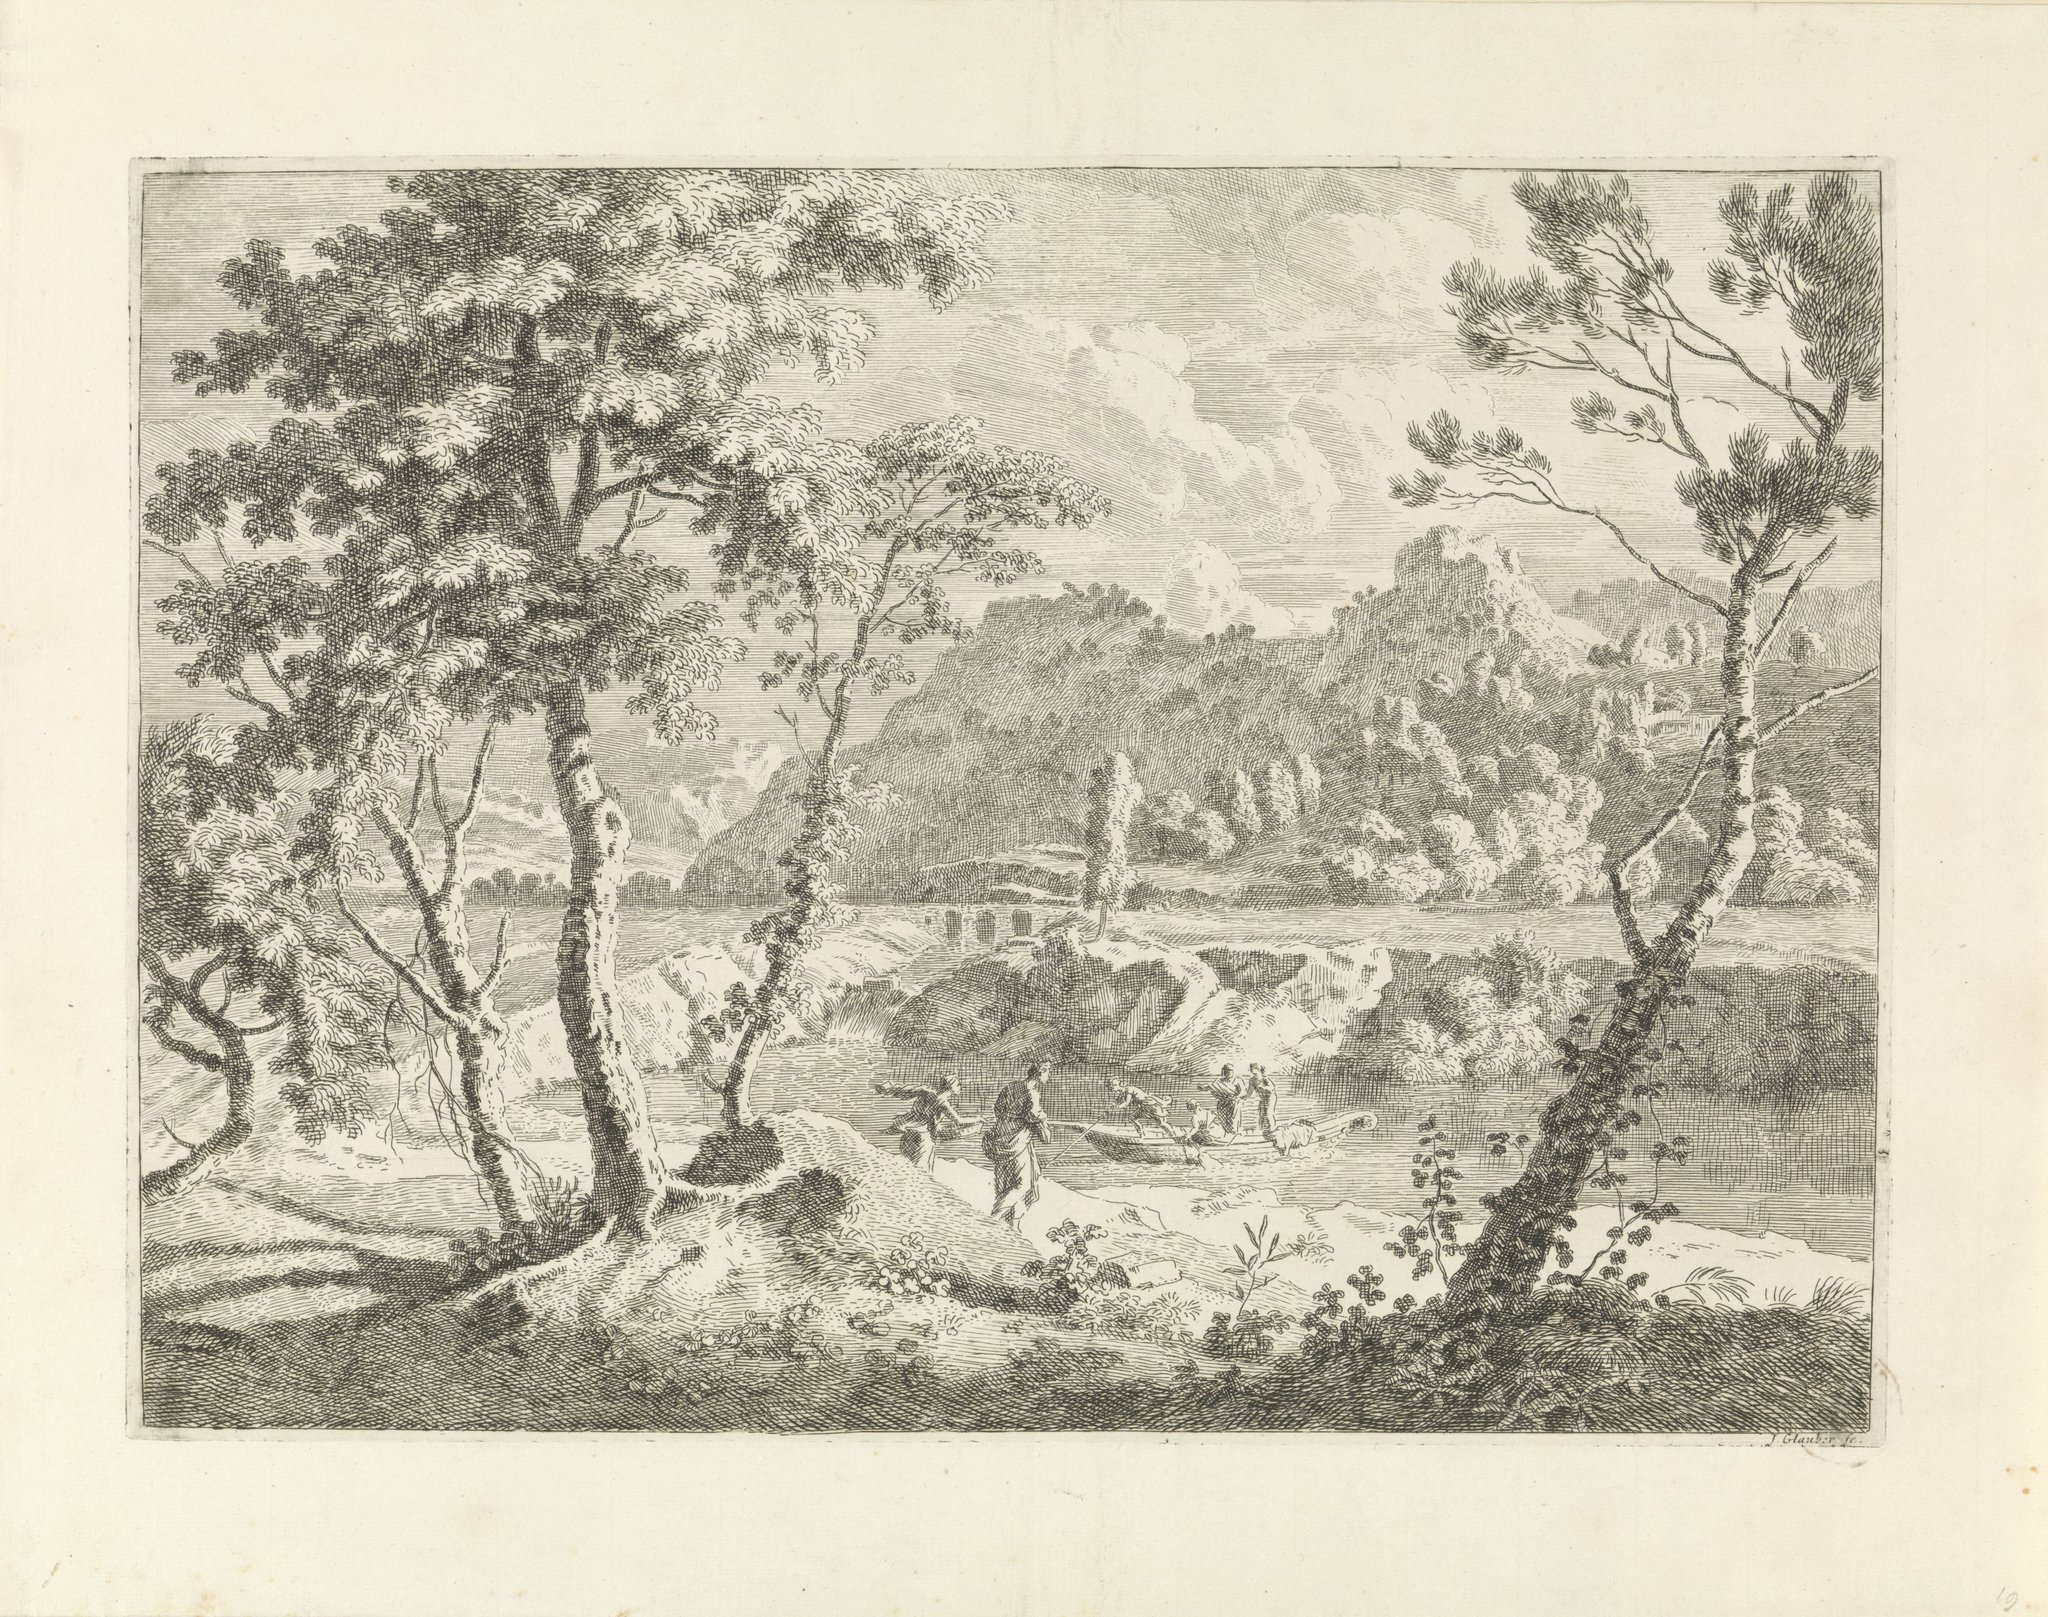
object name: print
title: Rivierlandschap met een boot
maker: johannes glauber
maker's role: draughtsman, painter, print maker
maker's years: 1646-1726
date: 1656-1726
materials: paper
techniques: etching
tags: (high) hill, rowing-boat, canoe, etc., river (+ landscape with figures, staffage)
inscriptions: collector's mark: Lugt 240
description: Een heuvelachtig landschap met een rivier. Een boot met vier passagiers op het water. Twee vrouwen aan de oever kijken toe.